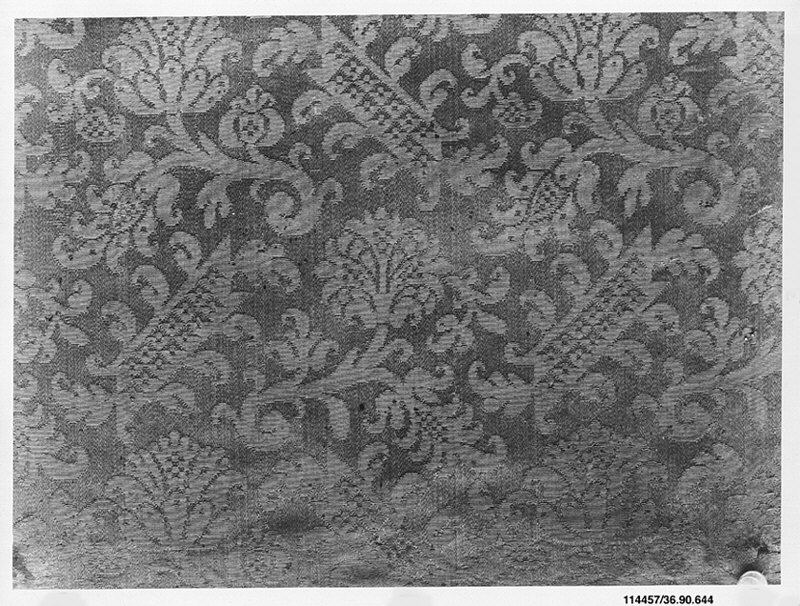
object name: piece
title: Woven silk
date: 1601-1633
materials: silk